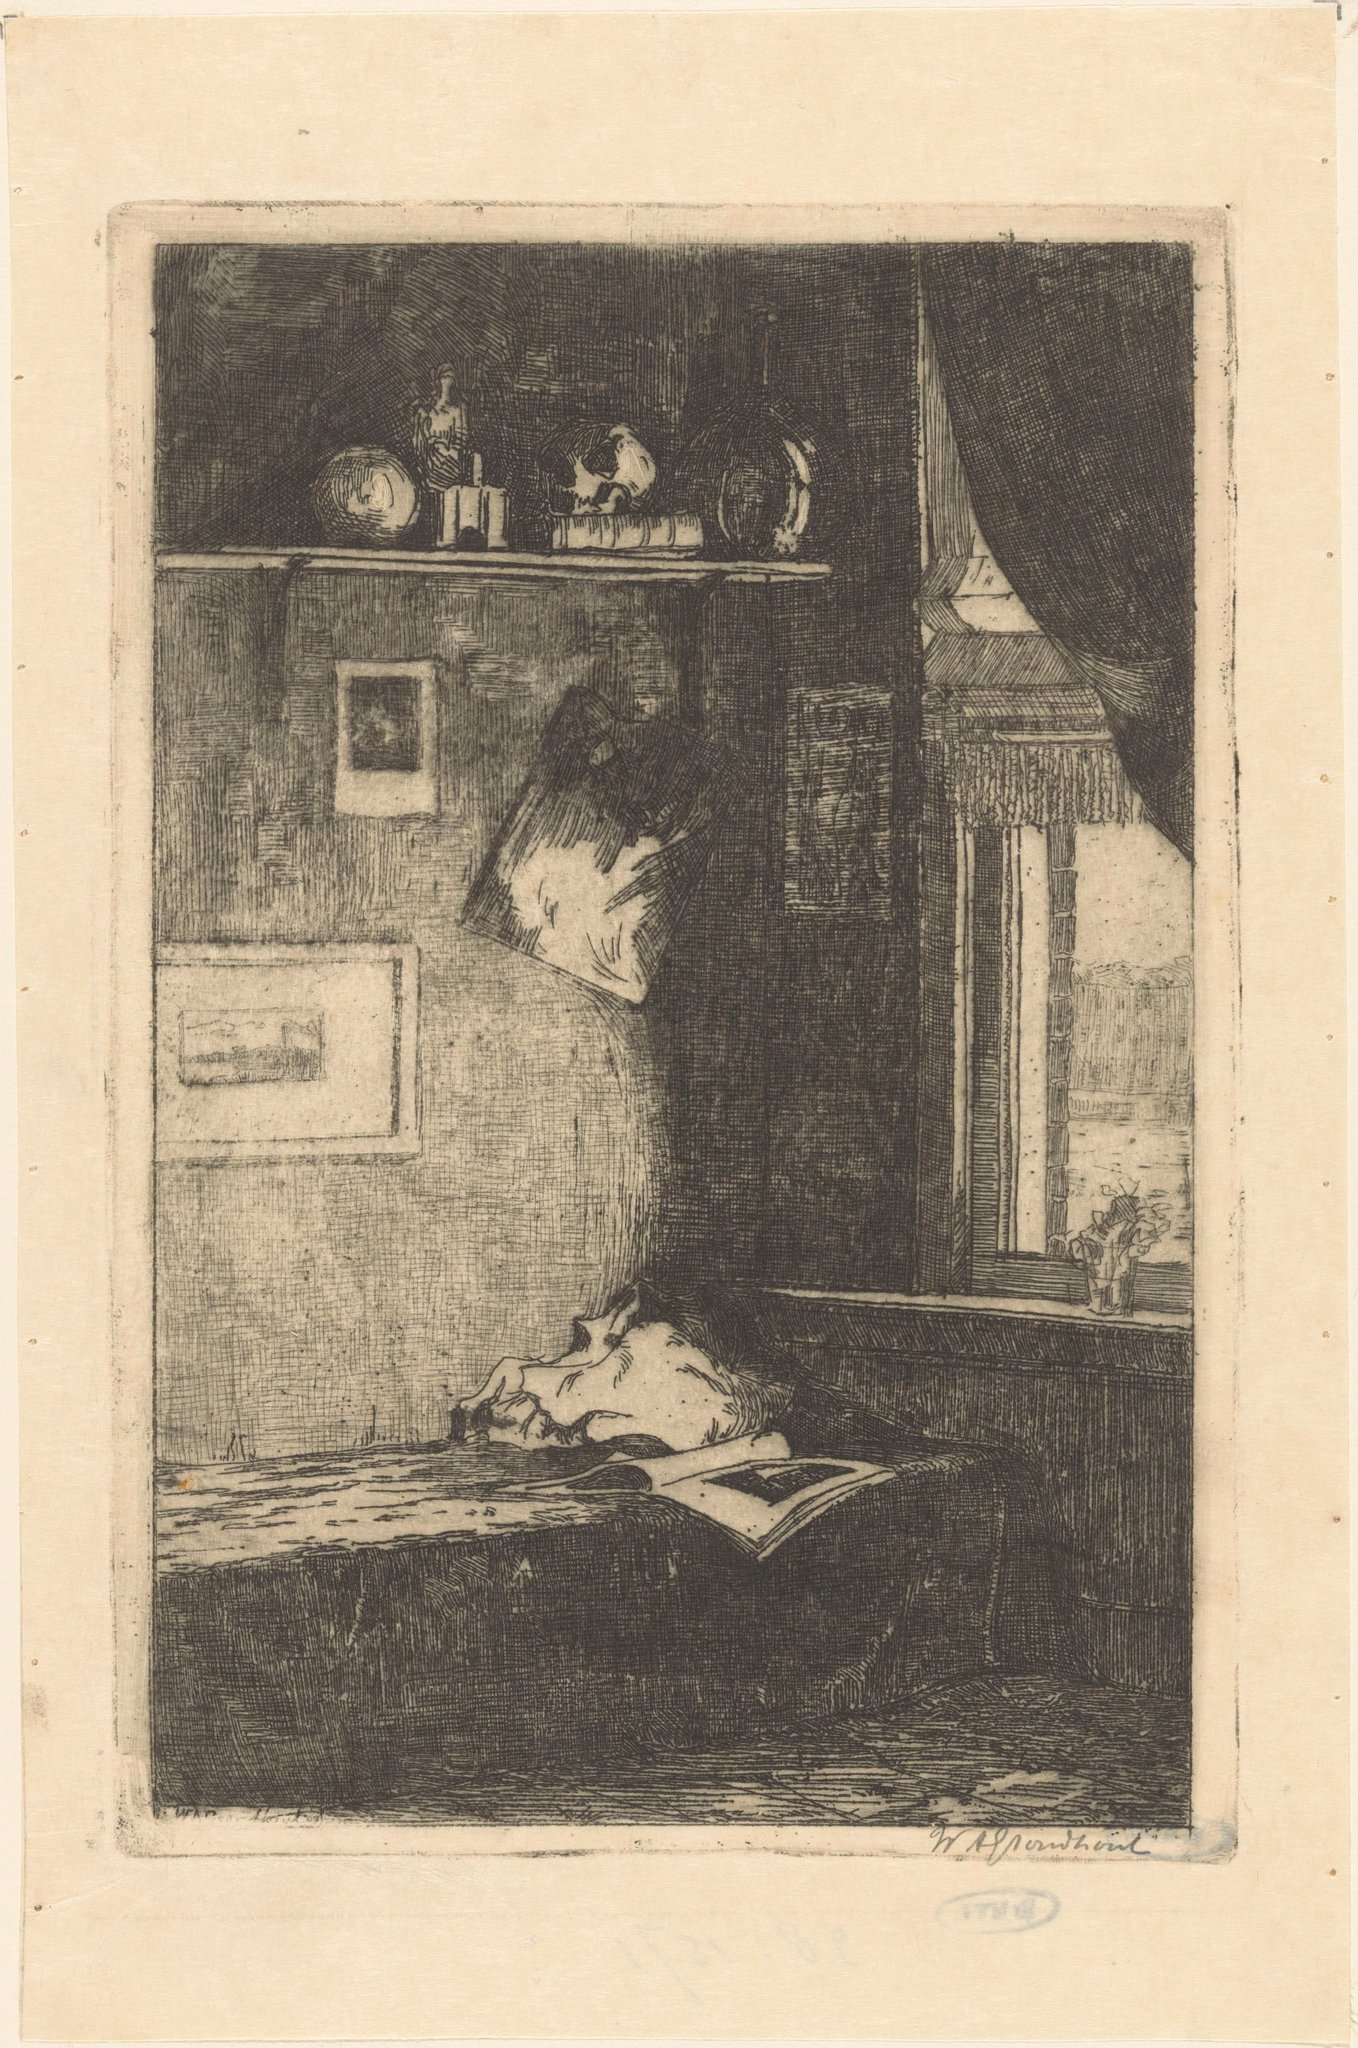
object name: print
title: Hoek van een atelier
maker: willem adrianus grondhout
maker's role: draughtsman, painter, print maker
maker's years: 1878-1934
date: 1888-1934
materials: paper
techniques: etching, intaglio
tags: workshop, studio of the artist (in general)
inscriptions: collector's mark: Lugt 2228